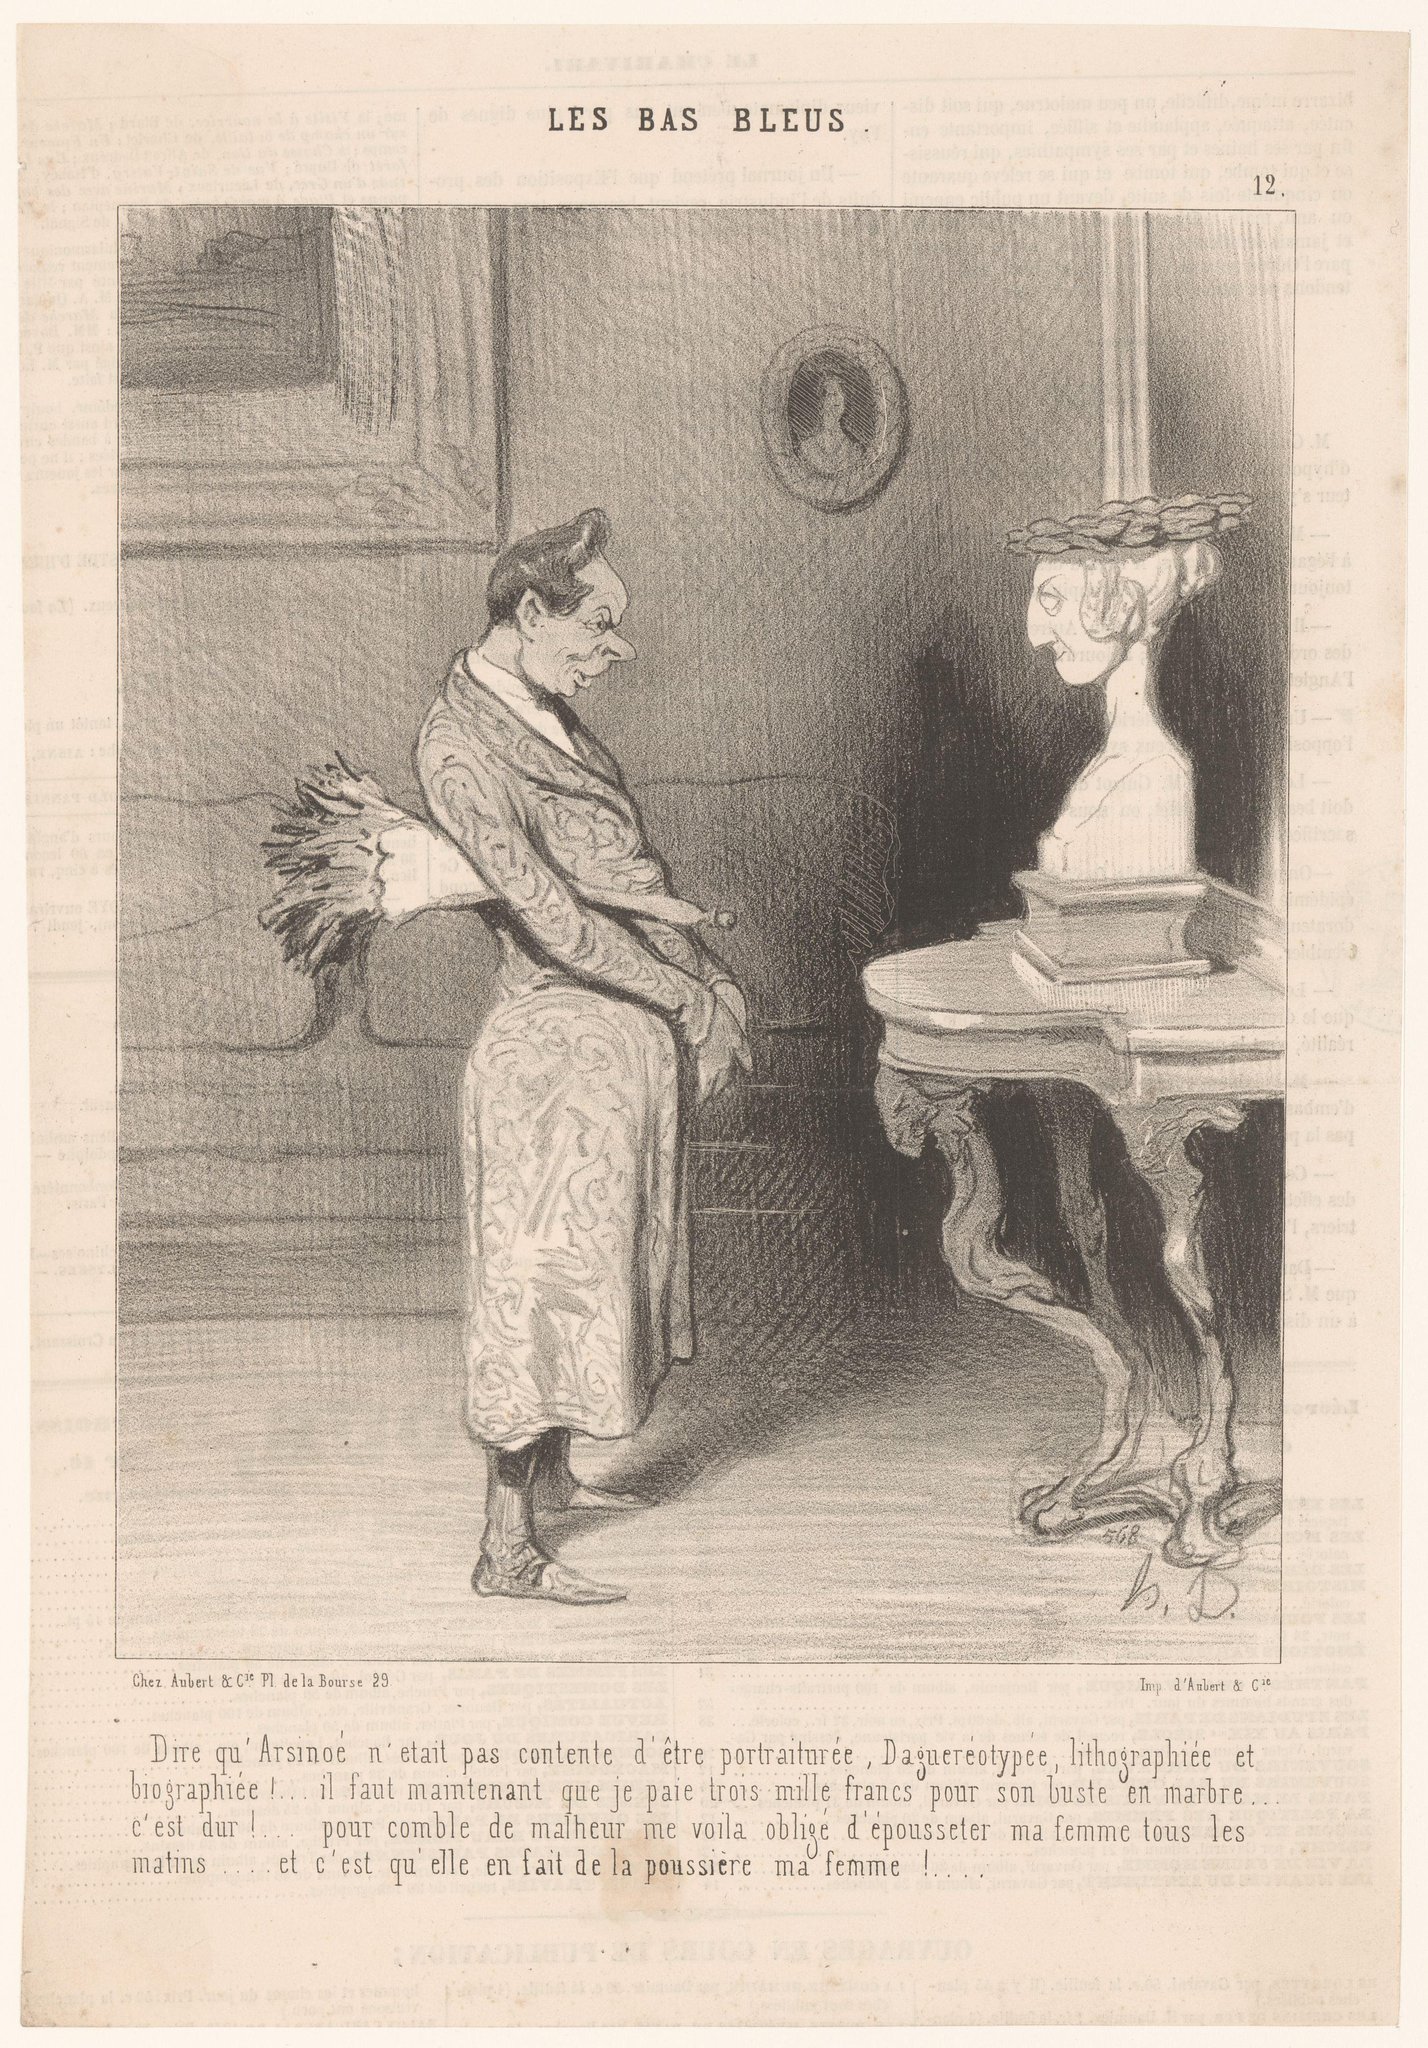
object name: cartoon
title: Pedante vrouwen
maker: honoré daumier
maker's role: draughtsman, painter, print maker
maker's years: 1808-1879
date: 1844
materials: paper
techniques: lithograph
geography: paris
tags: caricatures (human types), (household) utensils and implements (with name), portrait of a writer, sculpture, satire on marriage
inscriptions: collector's mark: Lugt 2228a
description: De man moppert dat hij iedere morgen de marmeren buste van zijn vrouw moet afstoffen.